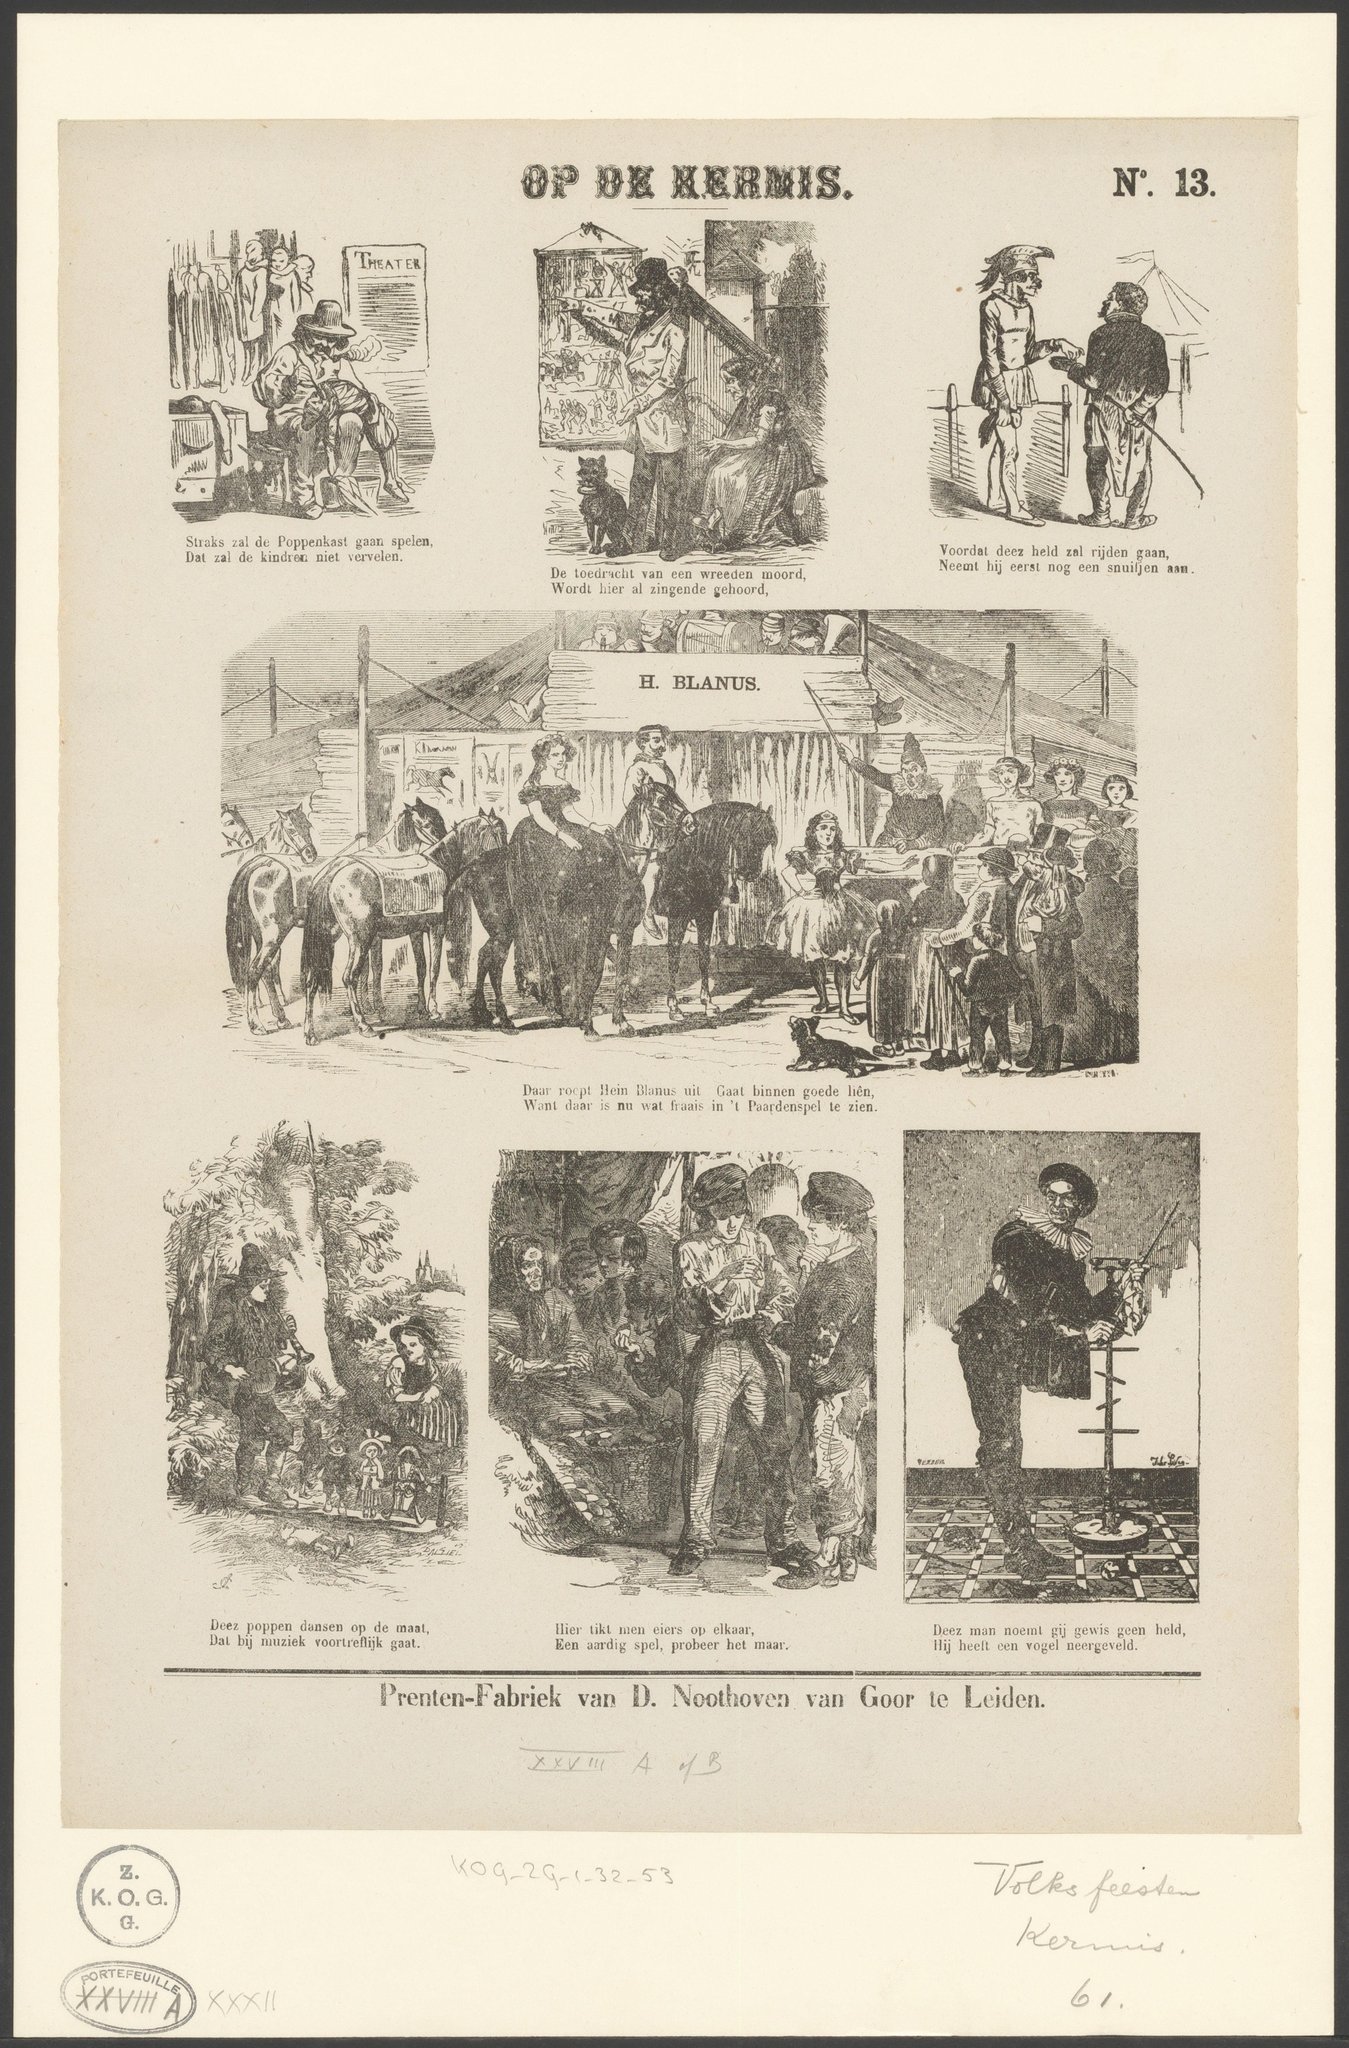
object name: popular print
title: Op de kermis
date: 1850-1881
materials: paper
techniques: engraving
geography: leiden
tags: pleasure fair and circus, clown, horses (circus performance), ballad singer, ballad seller - cc - out of doors, puppet and marionette show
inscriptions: collector's mark: Lugt 1641, collector's mark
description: Blad met zeven voorstellingen van kermisattracties, waaronder een zanger met een smartlap, het paardenspel van H. Blanus en een clown. Onder elke afbeelding een tweeregelig rijm. Genummerd rechtsboven: No. 13. Onderwerpsrubrieken binnen de Atlas Zeden en Gewoonten: Volksfeesten; Kermis.